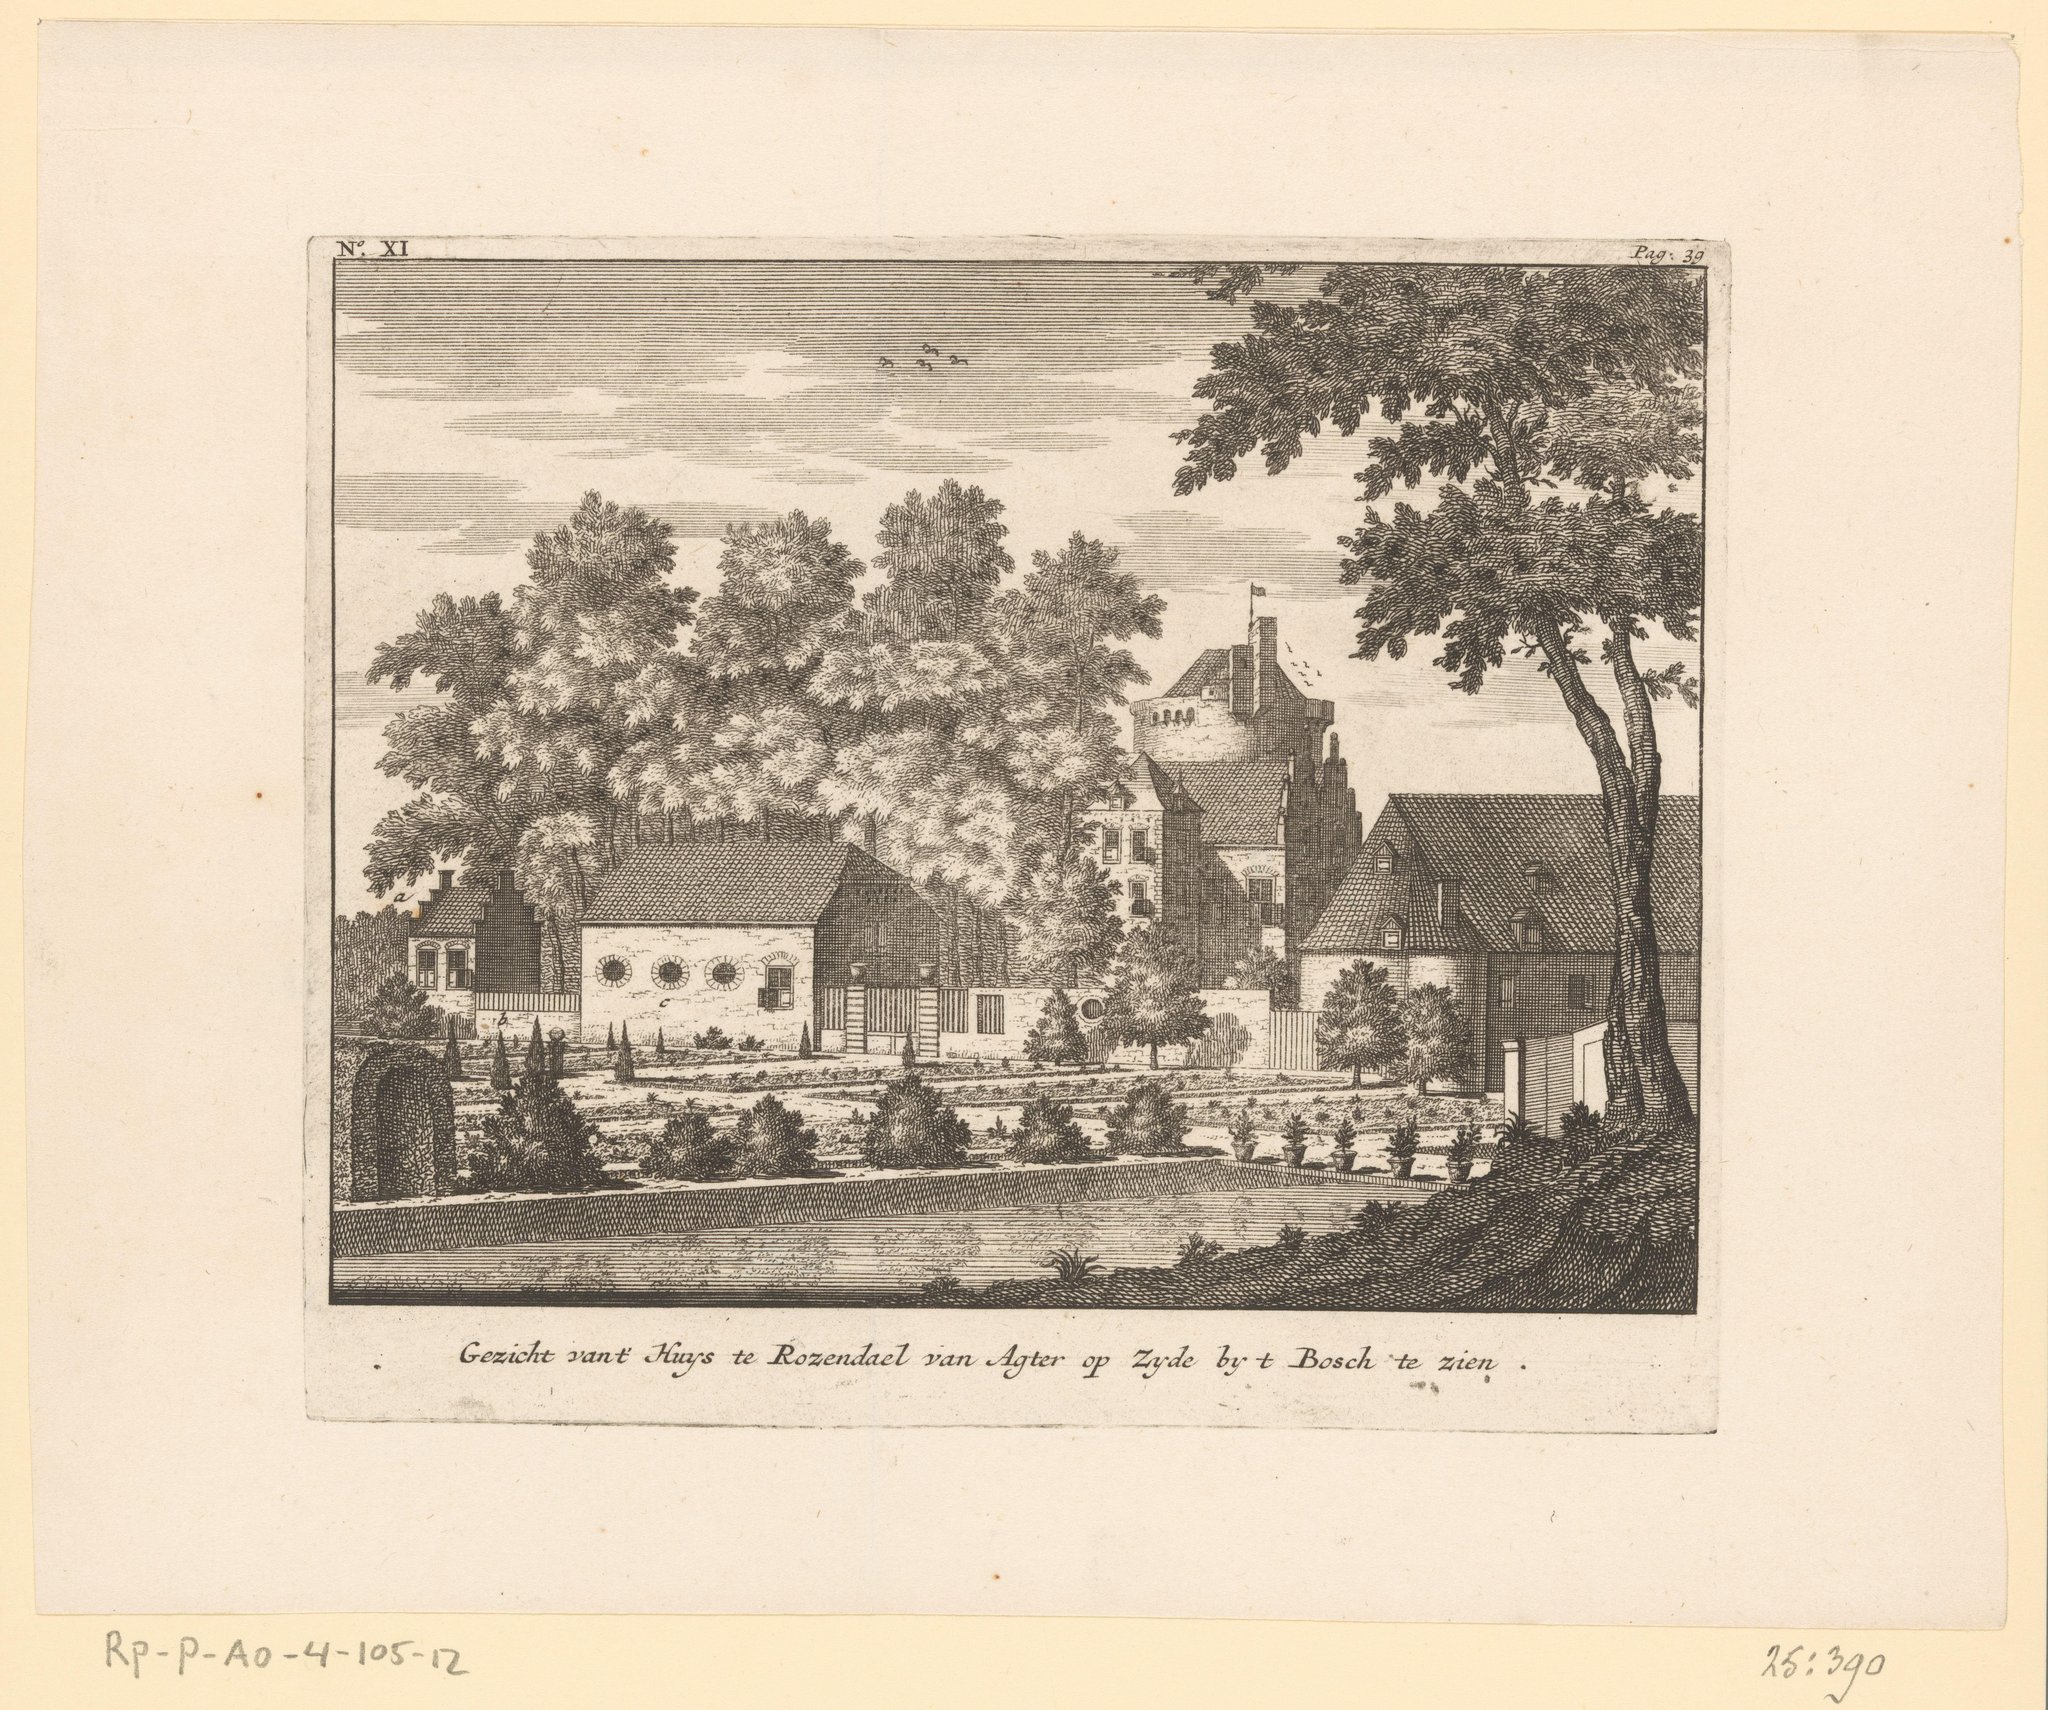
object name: print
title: Gezicht op Kasteel Rosendael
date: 1718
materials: paper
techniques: engraving, etching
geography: amsterdam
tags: castle, french or architectonic garden; formal garden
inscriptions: collector's mark: Lugt 195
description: Prent ook gebruikt in: Outrein, Johannes d’. Wegwyser door de heerlykheid Roosendaal ofte, de Roosendaalsche vermakelykheden. 3e druk. Amsterdam: Gerard van Keulen, 1718.